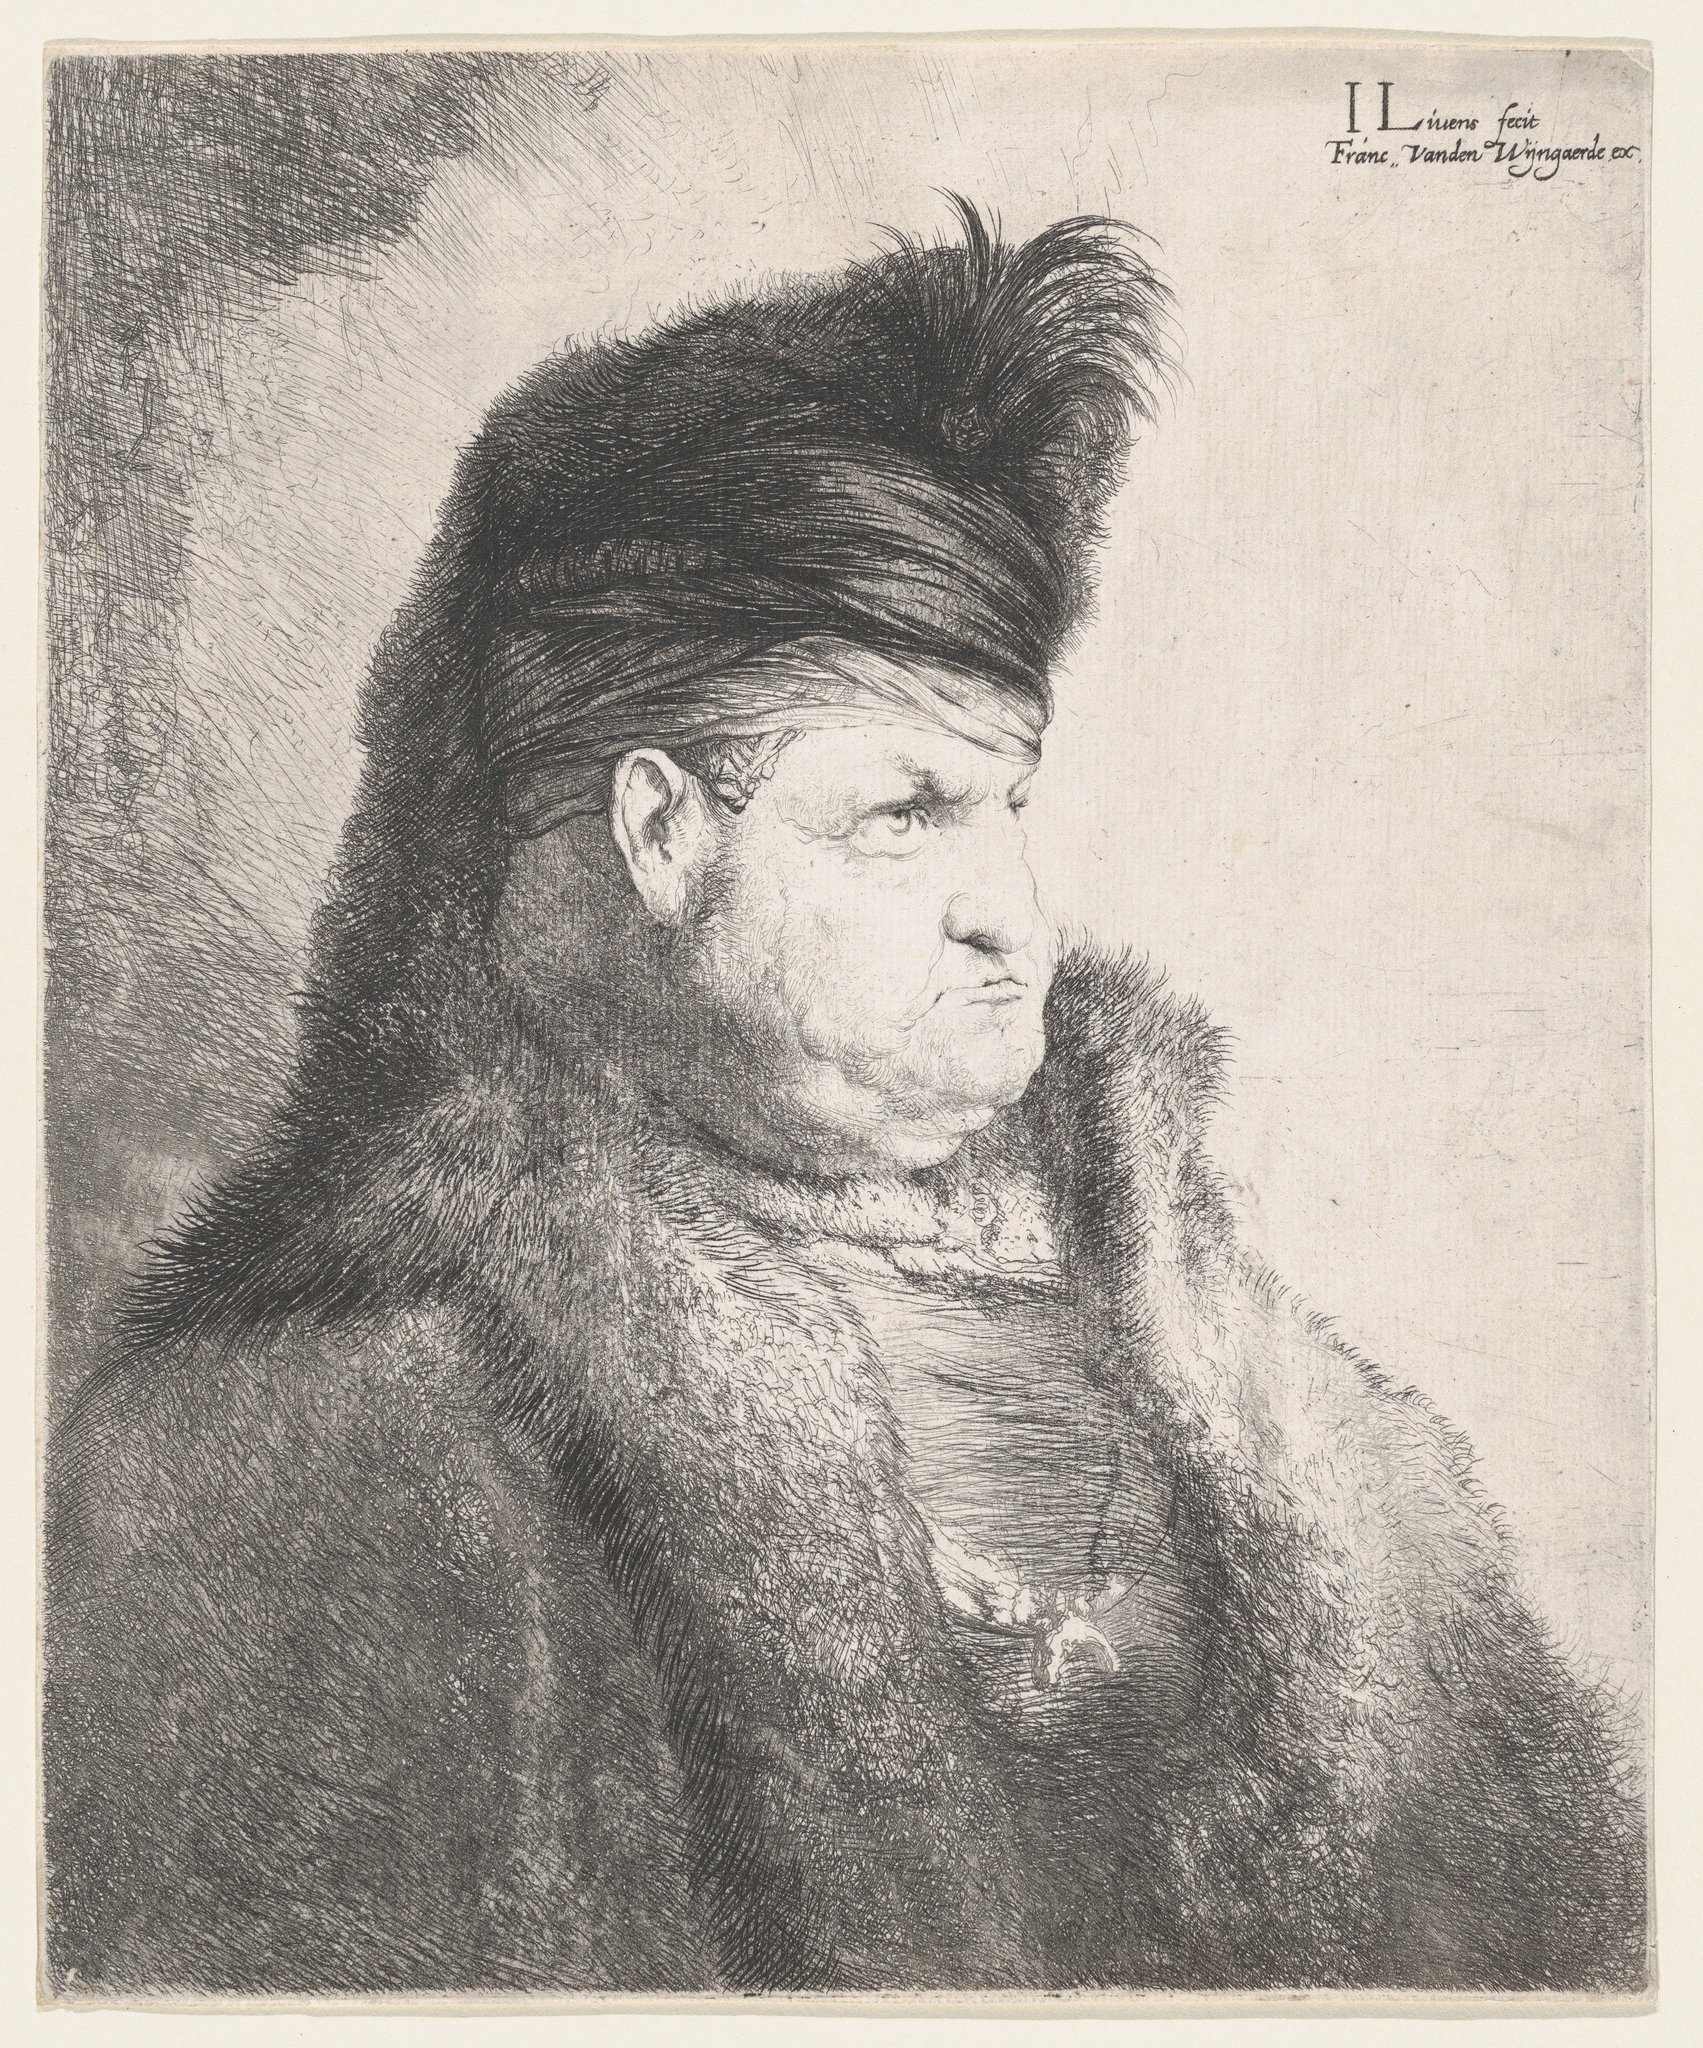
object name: print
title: Man in a Turban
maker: jan lievens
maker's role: artist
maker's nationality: dutch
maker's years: 1607-1674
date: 1601-1700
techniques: etching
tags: men